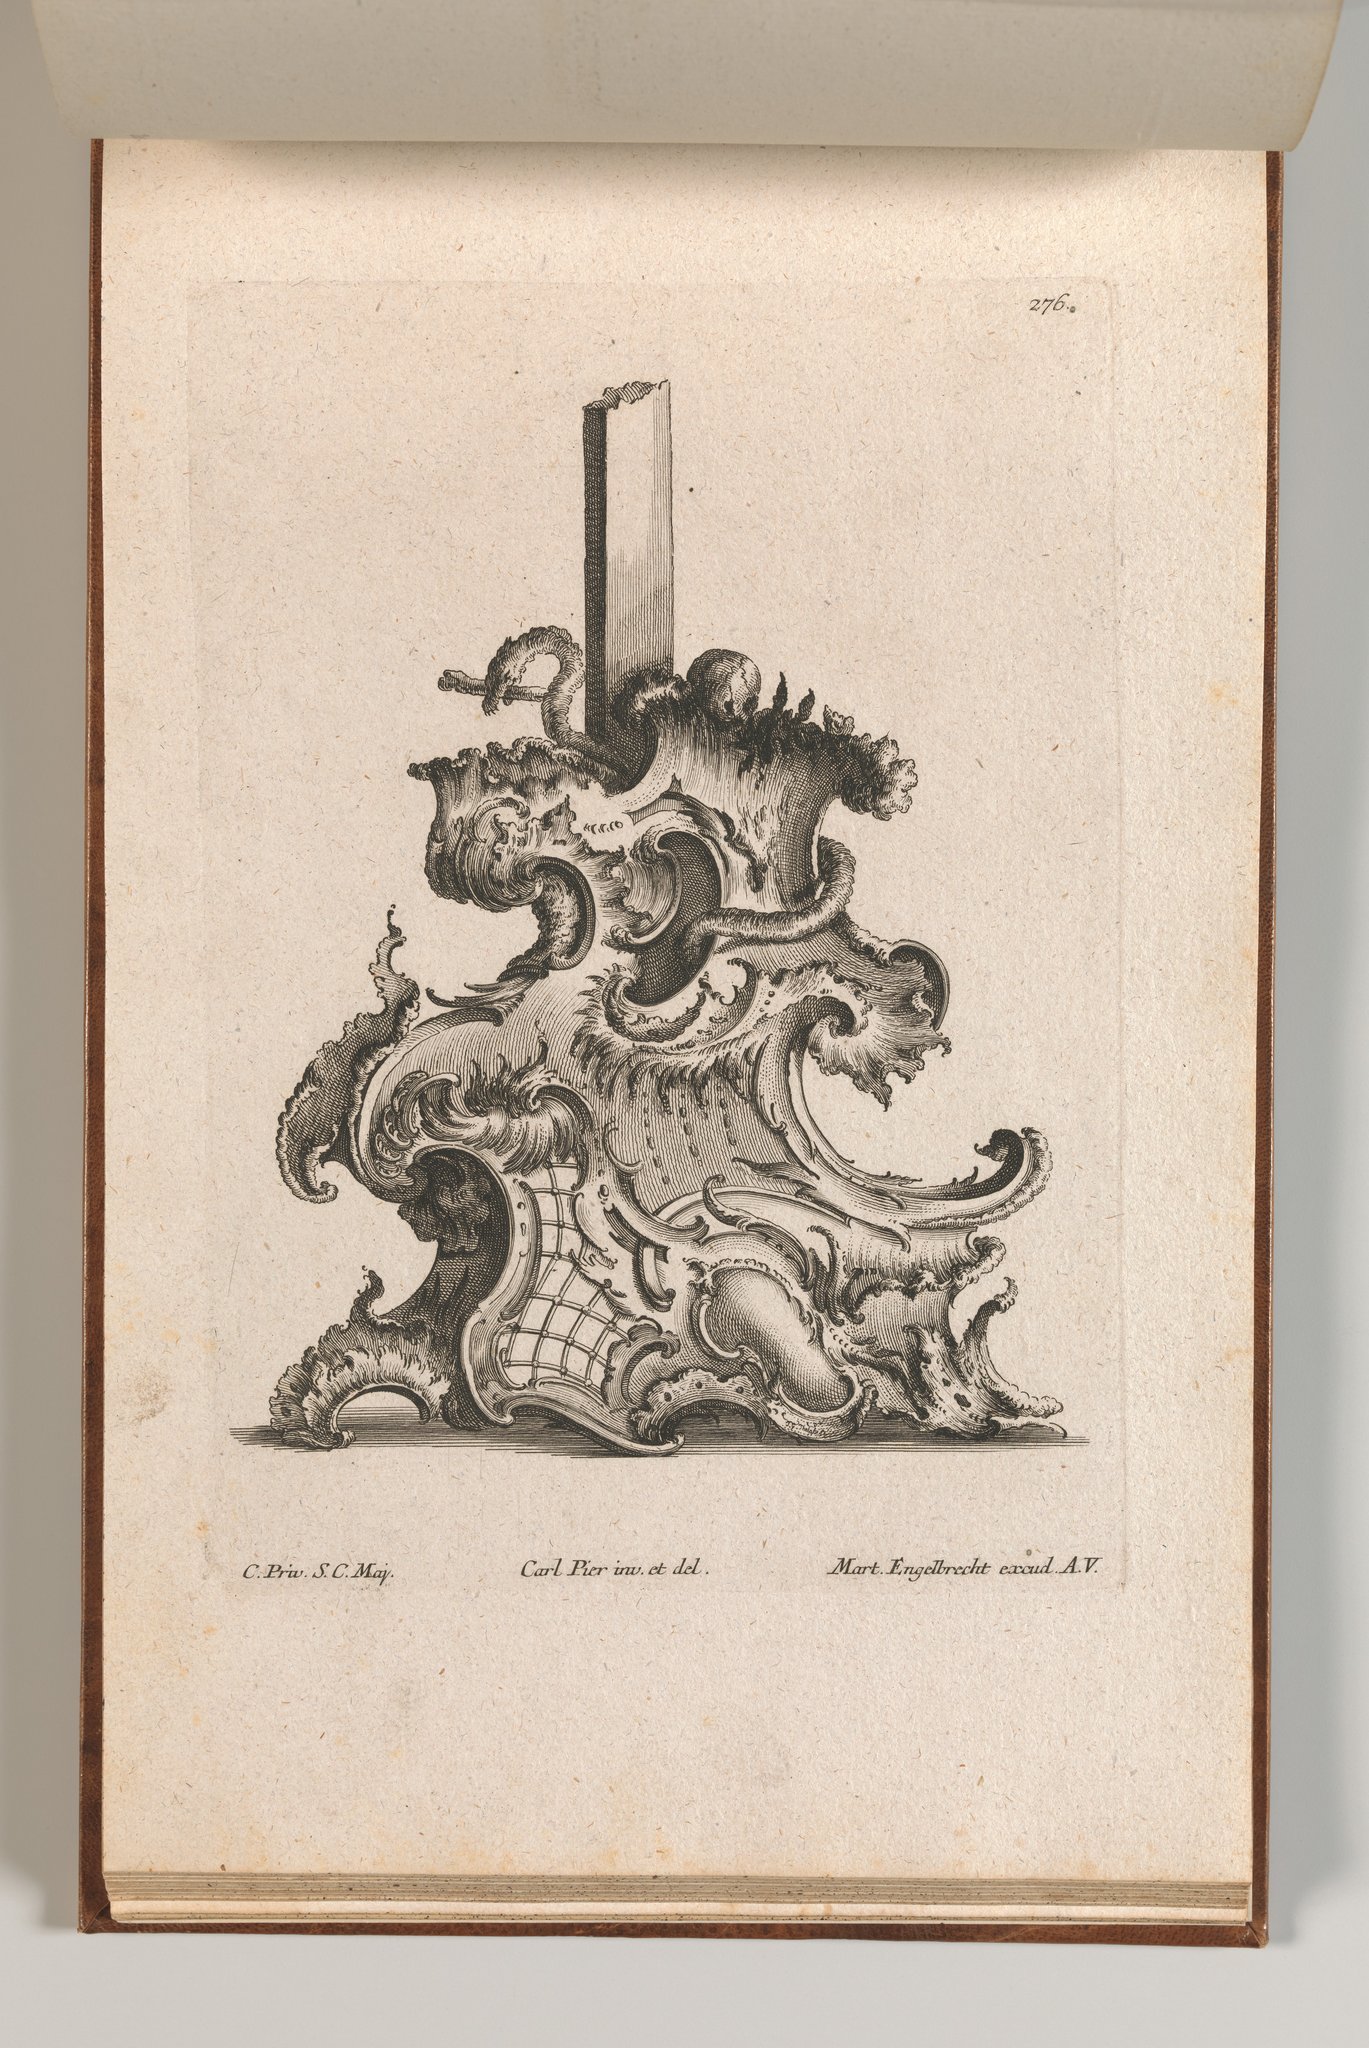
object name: album print ornament architecture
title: Design for the Base of a Crucifix, Plate 3 from: 'Neü inventierte Crucifix= Stöcke'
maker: jacob gottlieb thelot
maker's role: engraver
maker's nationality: central european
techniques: etching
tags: ornament